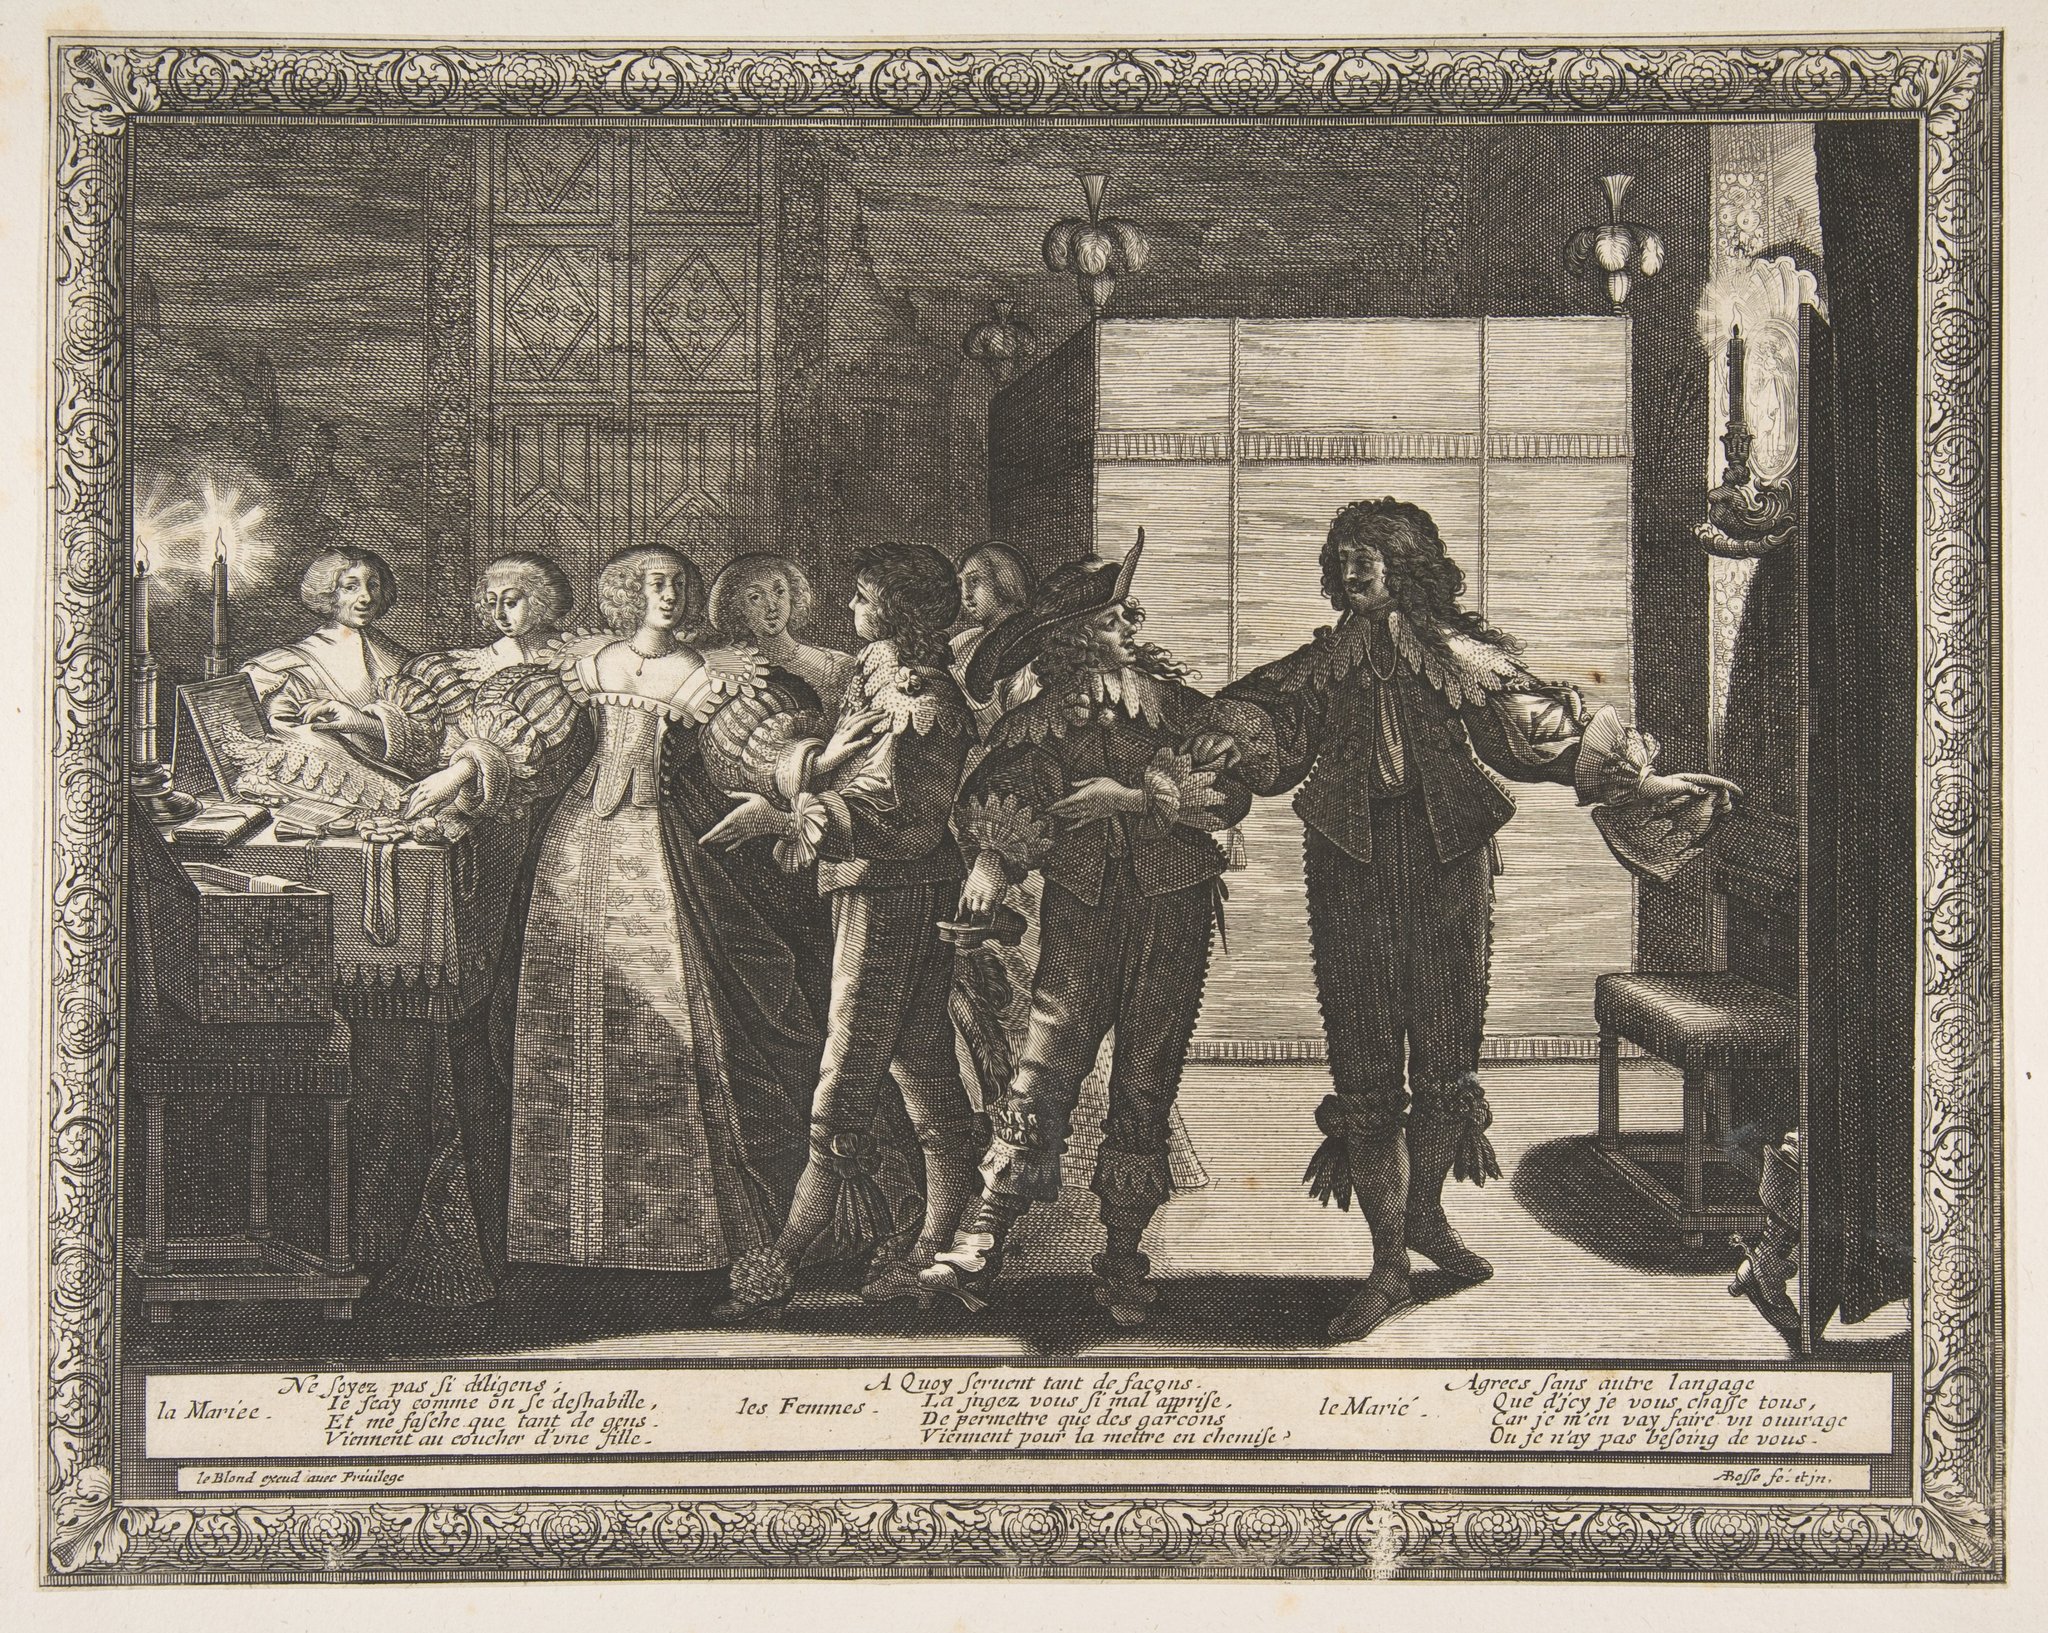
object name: print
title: The Bride Taken Home (La Mariée reconduite chez elle)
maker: abraham bosse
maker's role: artist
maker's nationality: french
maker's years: 1602-1676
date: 1633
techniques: etching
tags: men,women